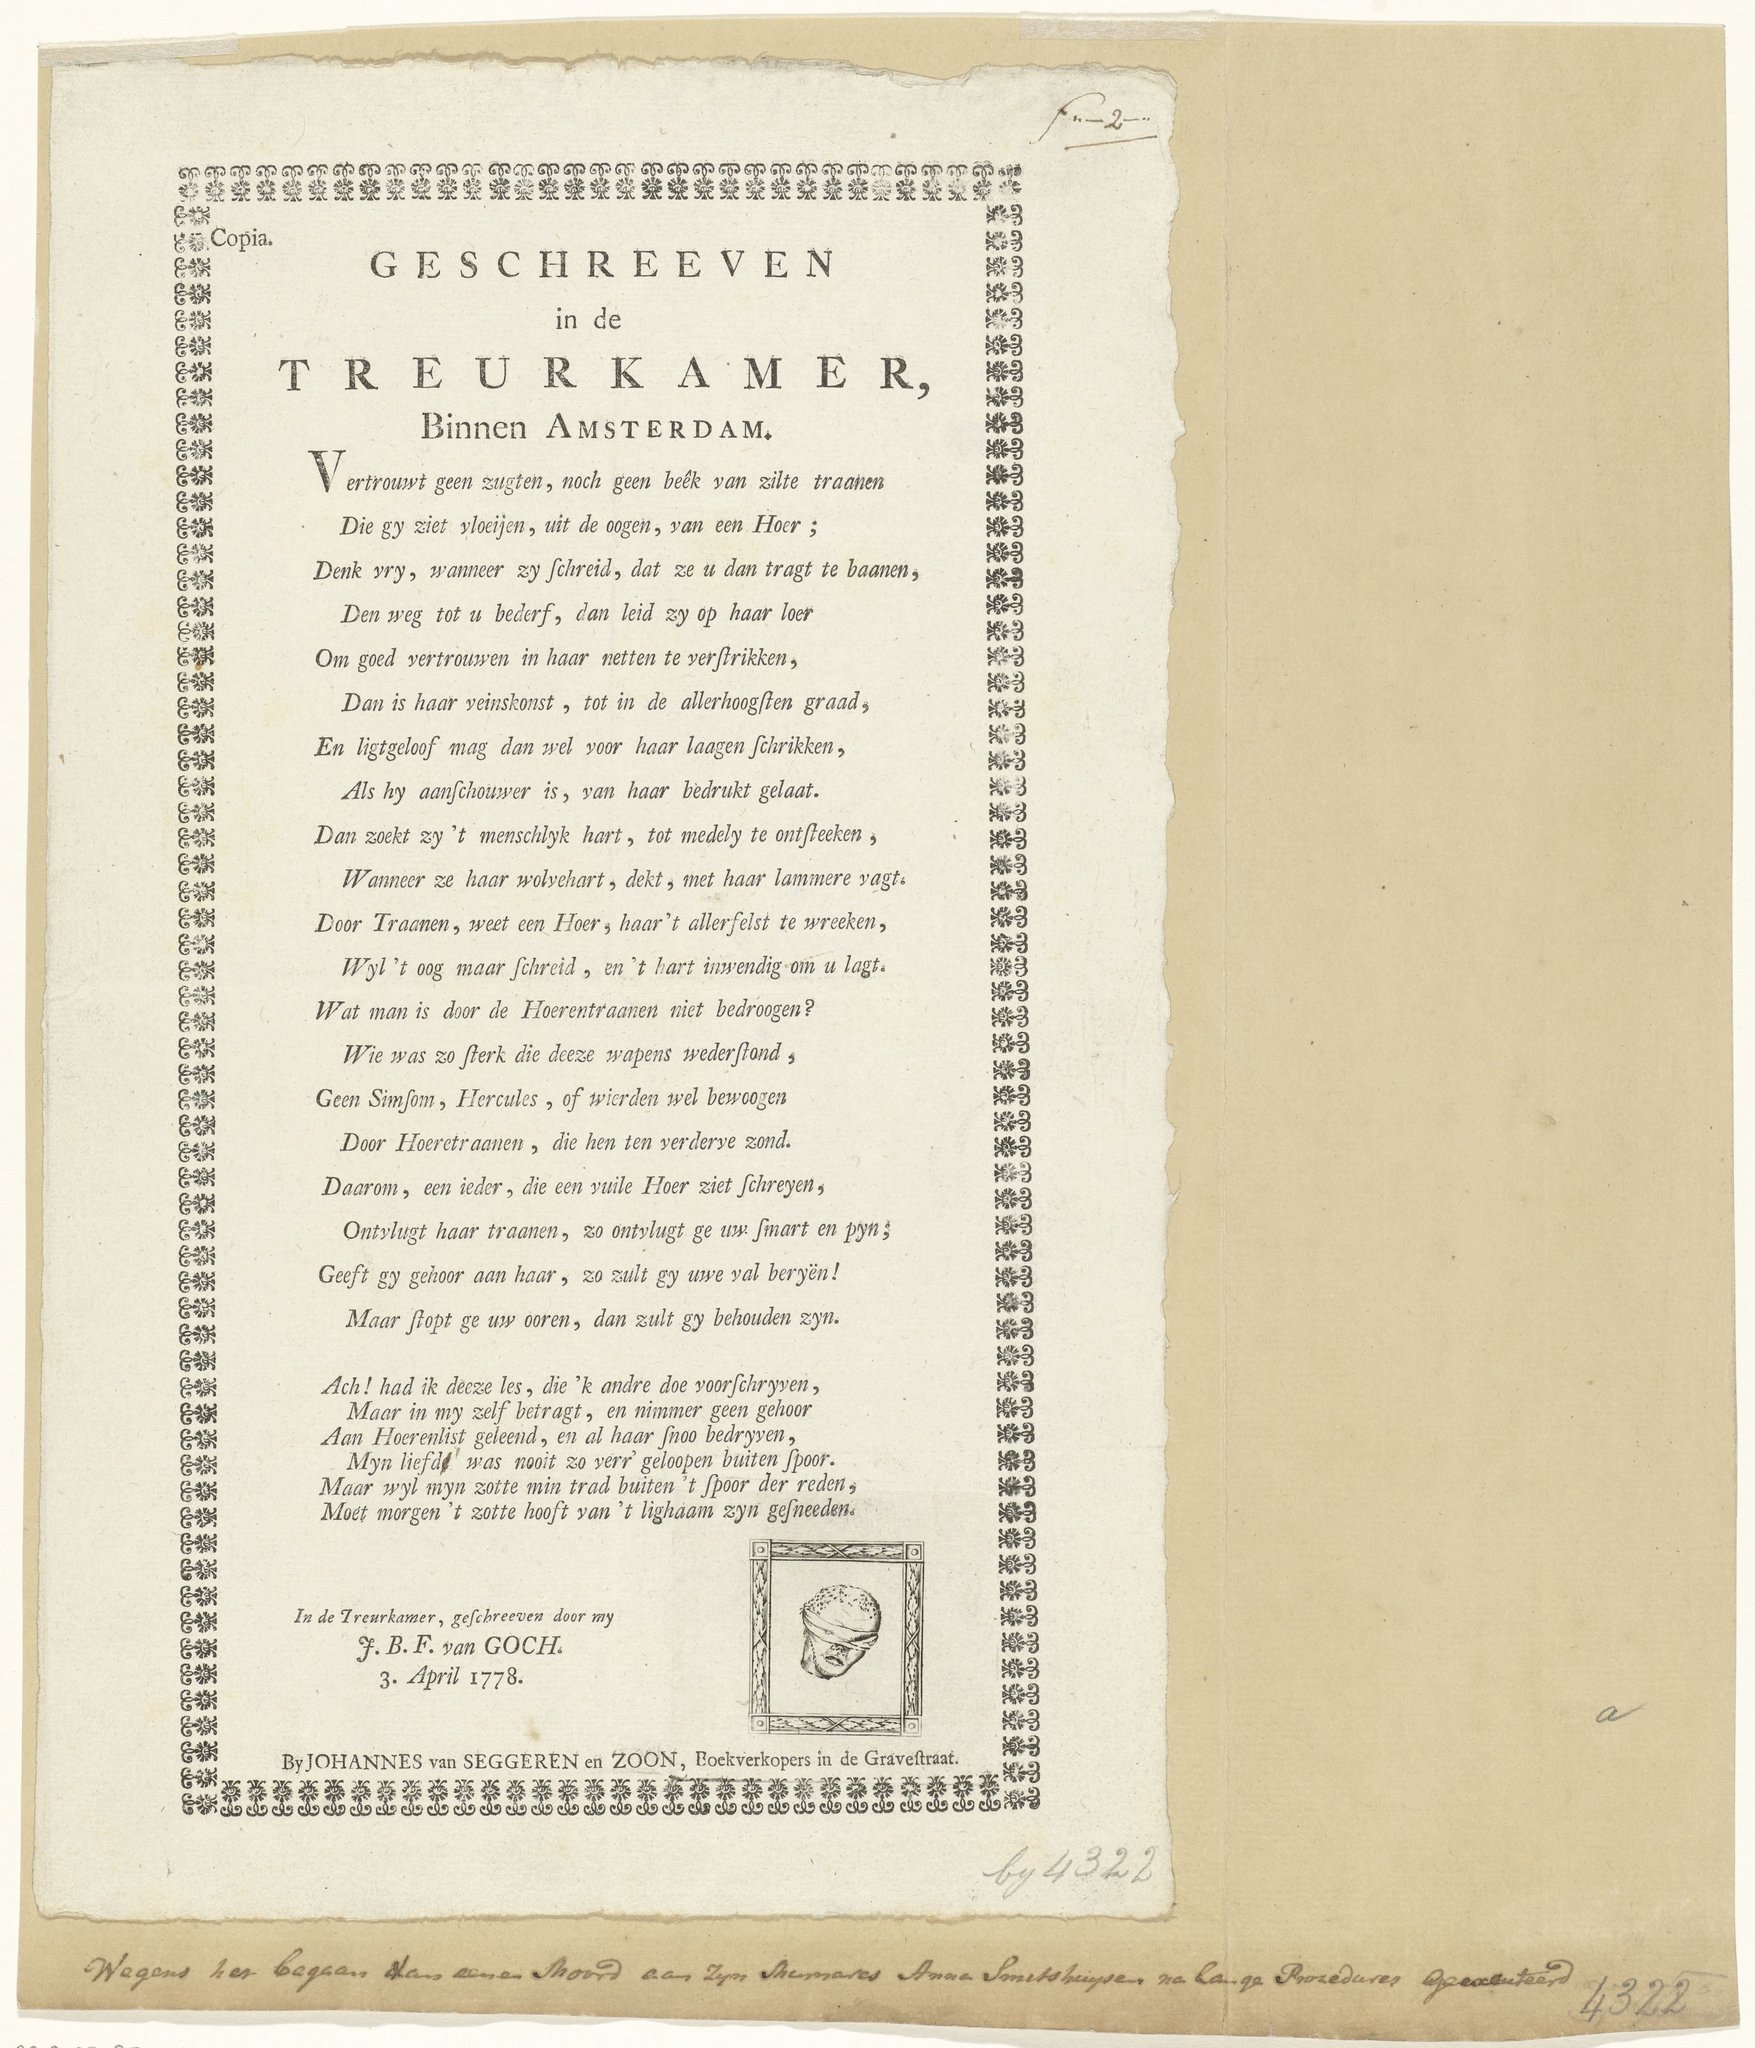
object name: print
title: Geschreeven in de Treurkamer, Binnen Amsterdam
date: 1778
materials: paper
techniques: engraving, letterpress printing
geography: northern netherlands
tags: amsterdam, johannes bartholomeus ferdinandus van gogh, head of a beheaded person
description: Blad met een vers geschreven door Johannes Bartholomeus Ferdinandus van Gogh in gevangenschap de dag voor zijn onthoofding te Amsterdam op 4 april 1778. Van Gogh werd ter dood veroordeeld voor de moord op zijn geliefde, de prostituee Anna Smitshuizen. Onderaan een kleine plaat van het afgesneden en geblinddoekte hoofd van de veroordeelde.